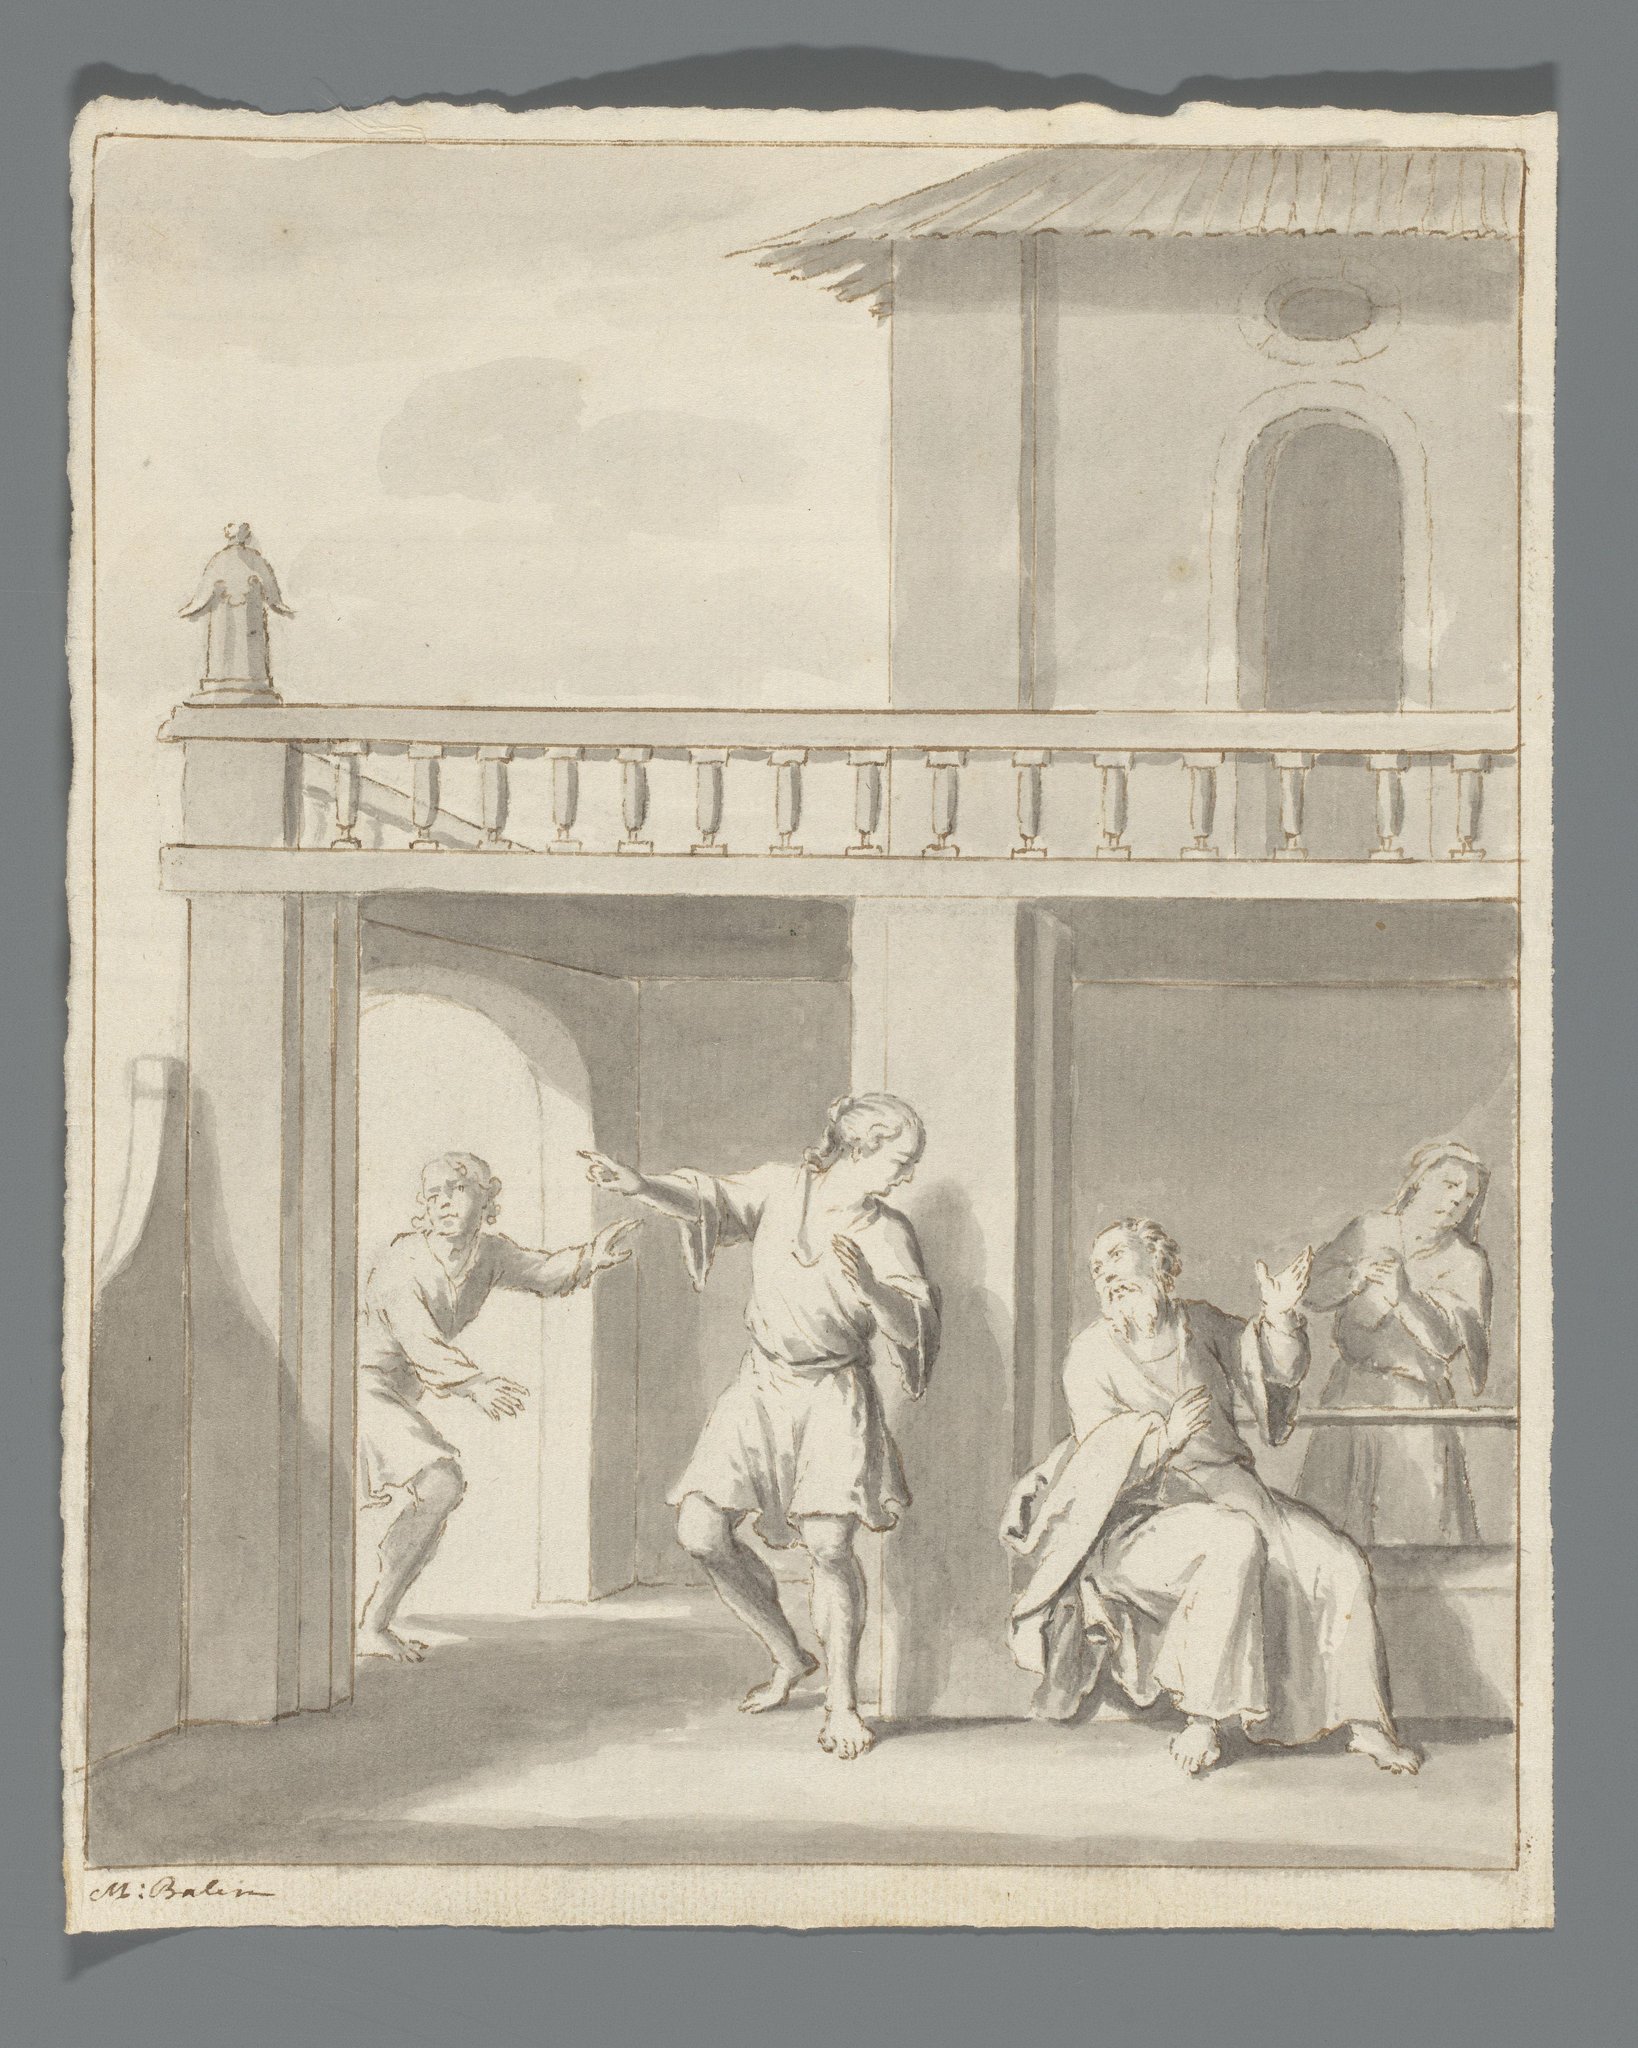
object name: drawing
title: Binnenplaats met oudere man, vrouw en twee jongere mannen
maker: matthijs balen (1684-1766)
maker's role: draughtsman, painter, print maker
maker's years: 1684-1766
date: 1694-1766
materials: paper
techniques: brush, pen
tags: family, relationship, descent, courtyard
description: Waarschijnlijk een Bijbels tafereel, mogelijk Isaak en zijn zonen of Jakob die hoort dat Jozef dood is.